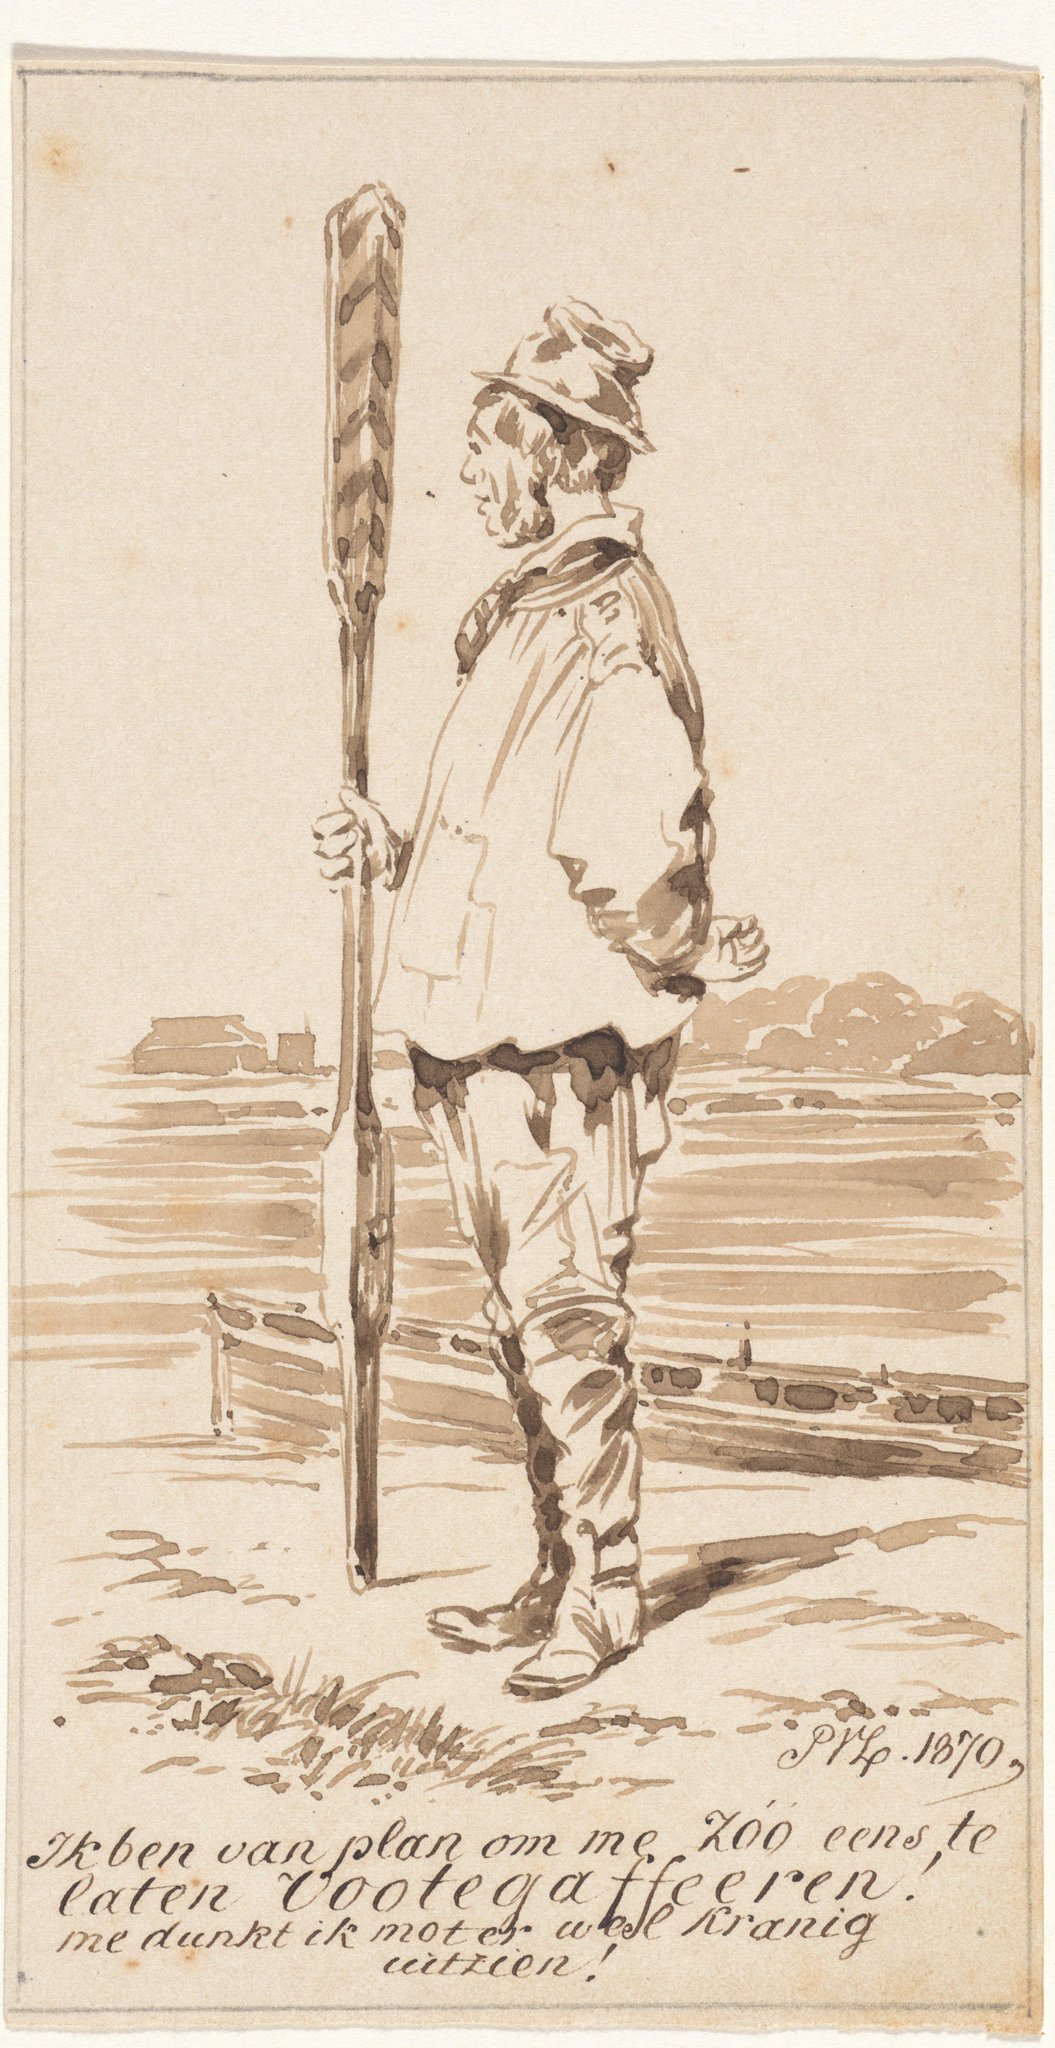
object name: drawing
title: Staande bootsman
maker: pieter van loon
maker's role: draughtsman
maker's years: 1801-1873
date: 1870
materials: paper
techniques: brush, pen